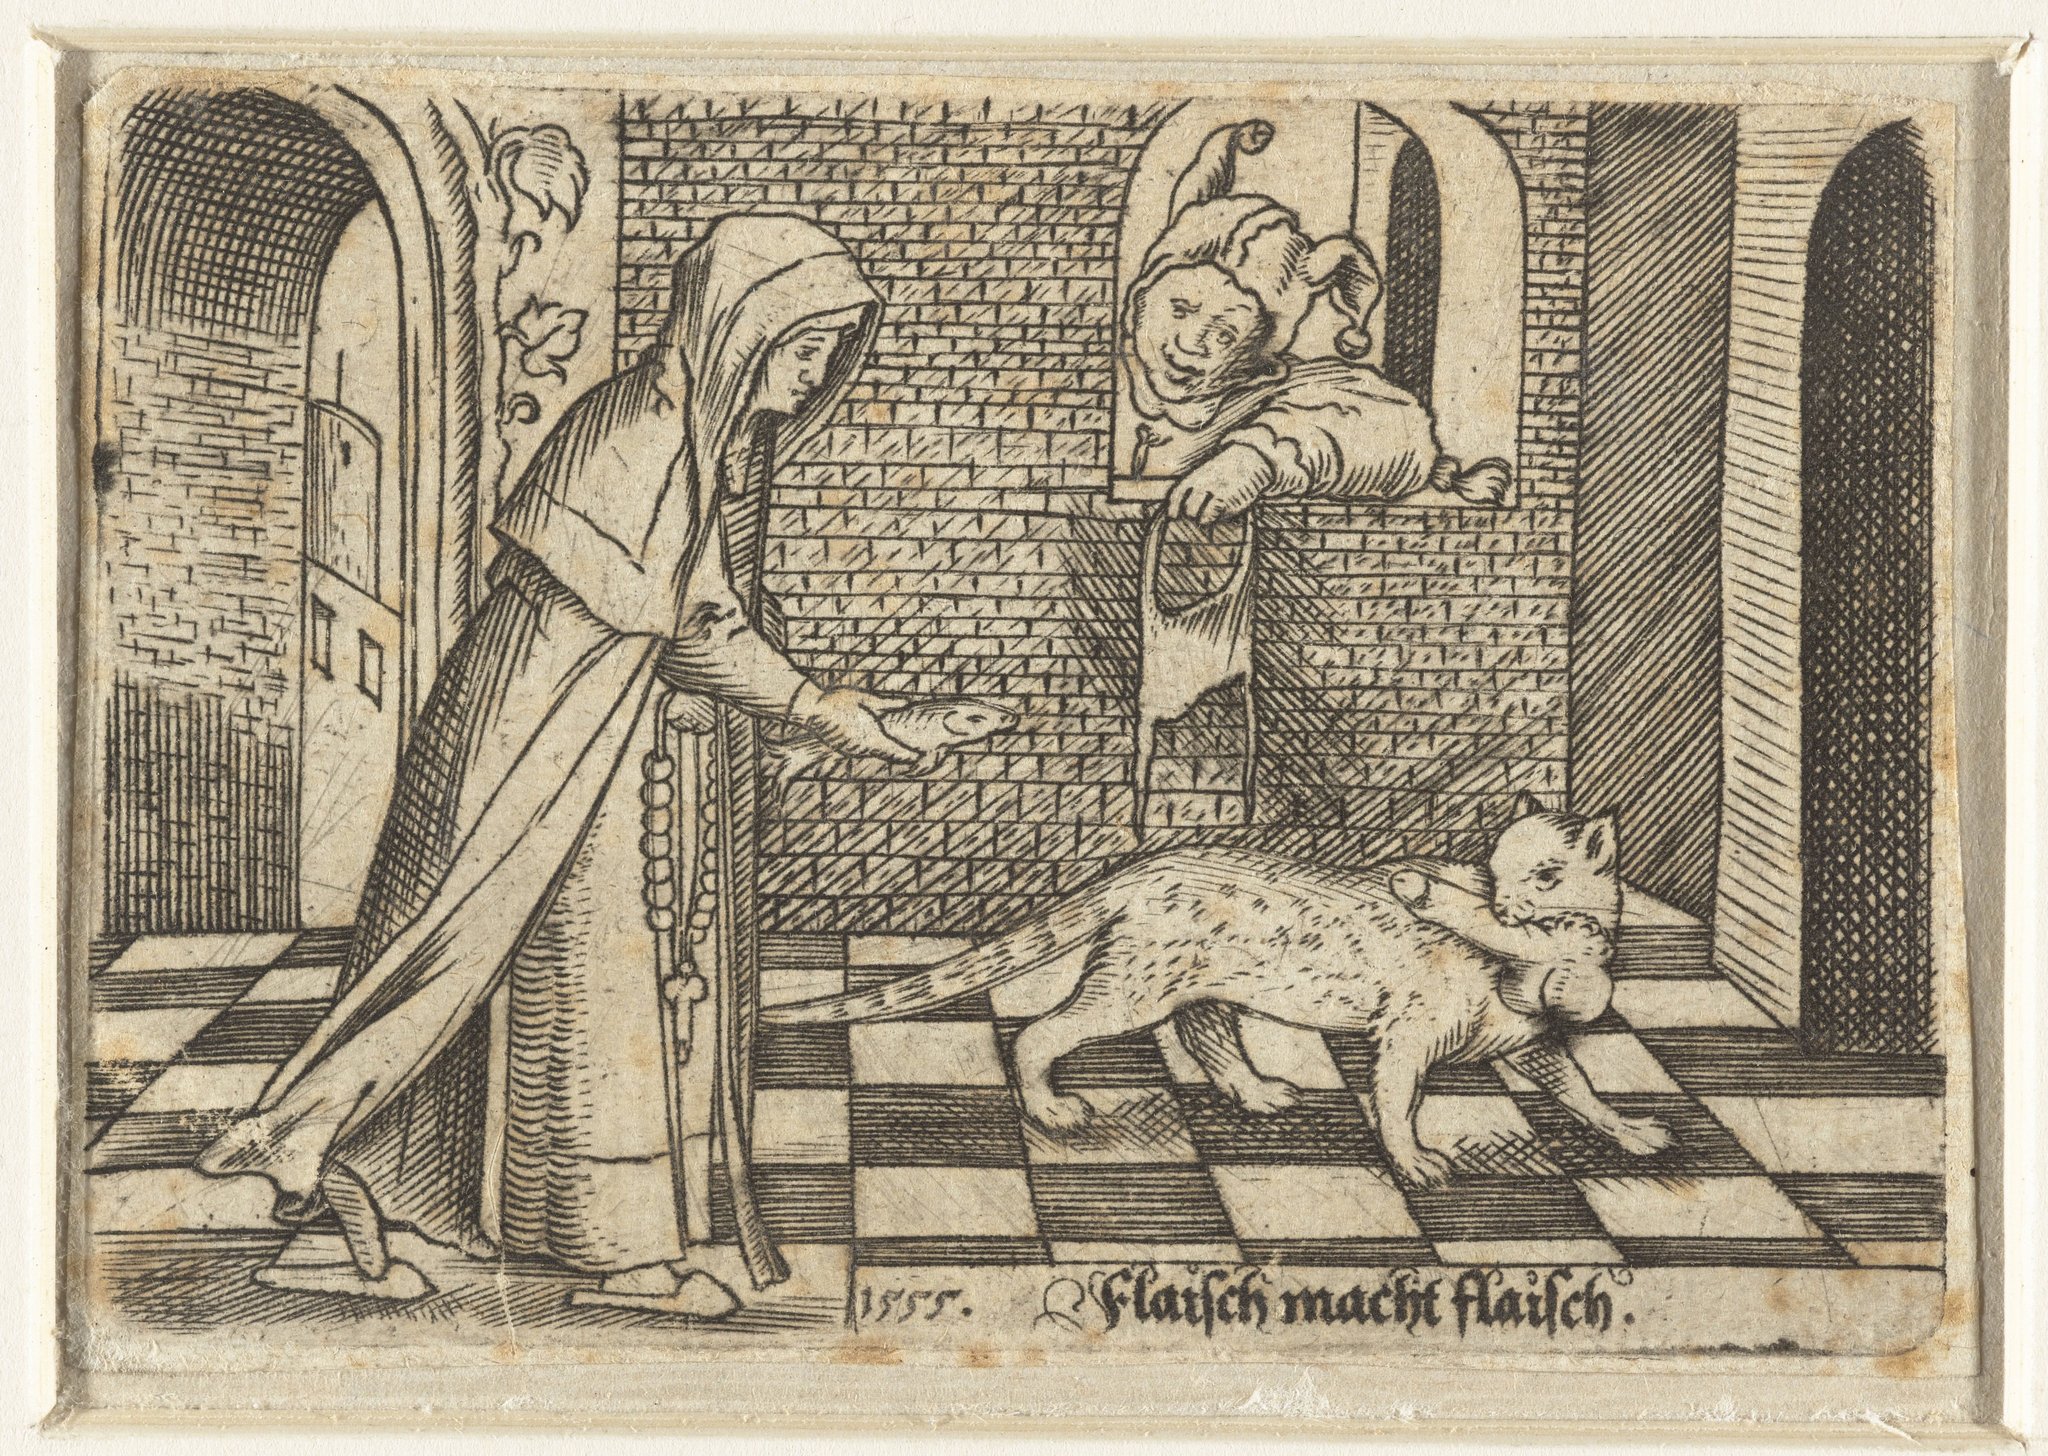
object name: print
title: Non biedt kat vis aan in ruil voor penis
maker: Anonymous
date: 1555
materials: paper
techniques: engraving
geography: germany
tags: cat, fool, simpleton, numskull, nun(s)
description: Non loopt met vis in de hand een kat achterna, zij wil de vis ruilen met een penis die de kat in de bek heeft. Een nar kijkt toe door een raamkozijn.